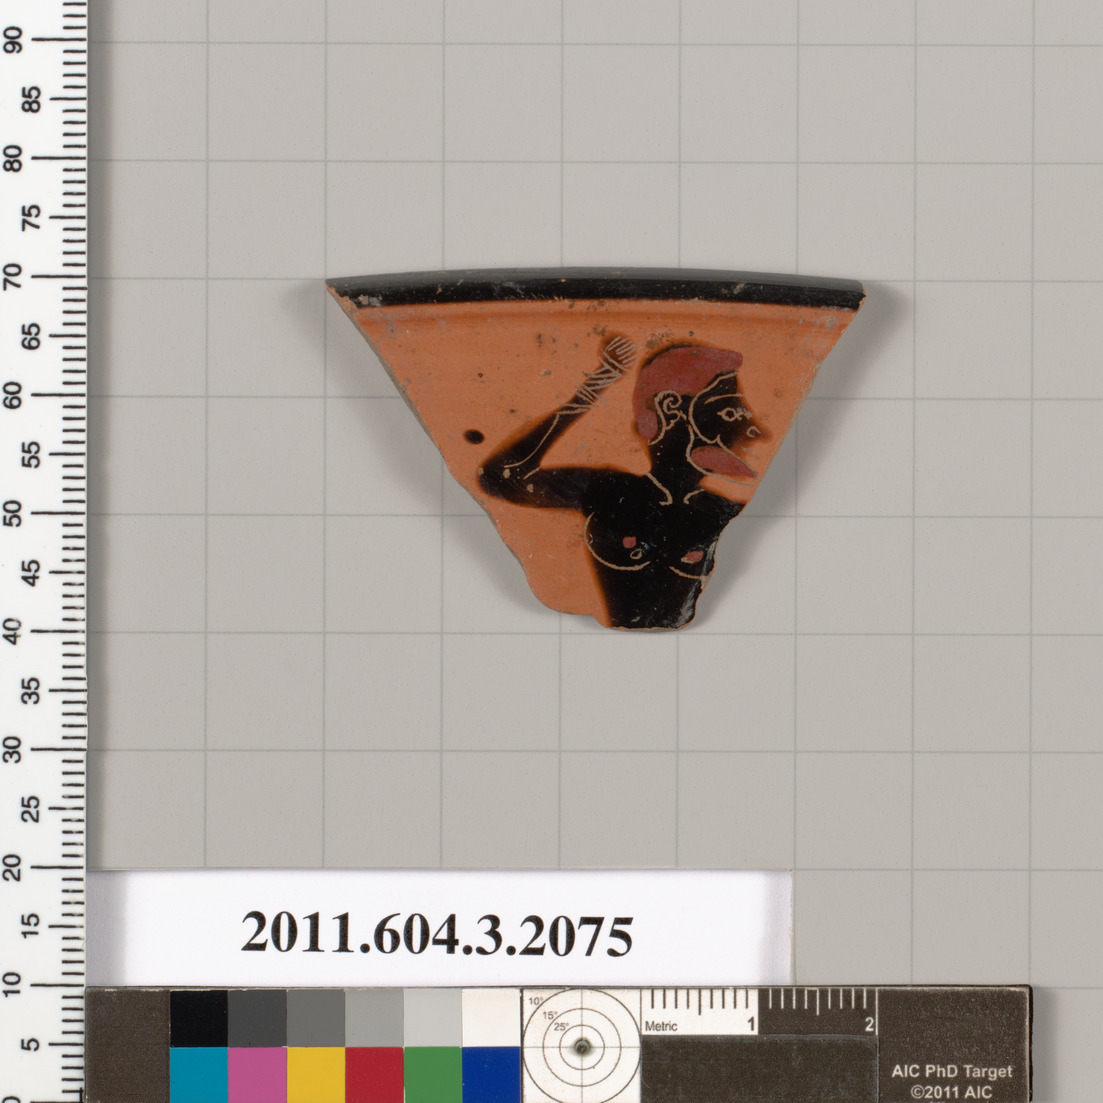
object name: kylix fragment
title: Terracotta rim fragment of a kylix (drinking cup)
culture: greek, attic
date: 525-501 BCE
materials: terracotta